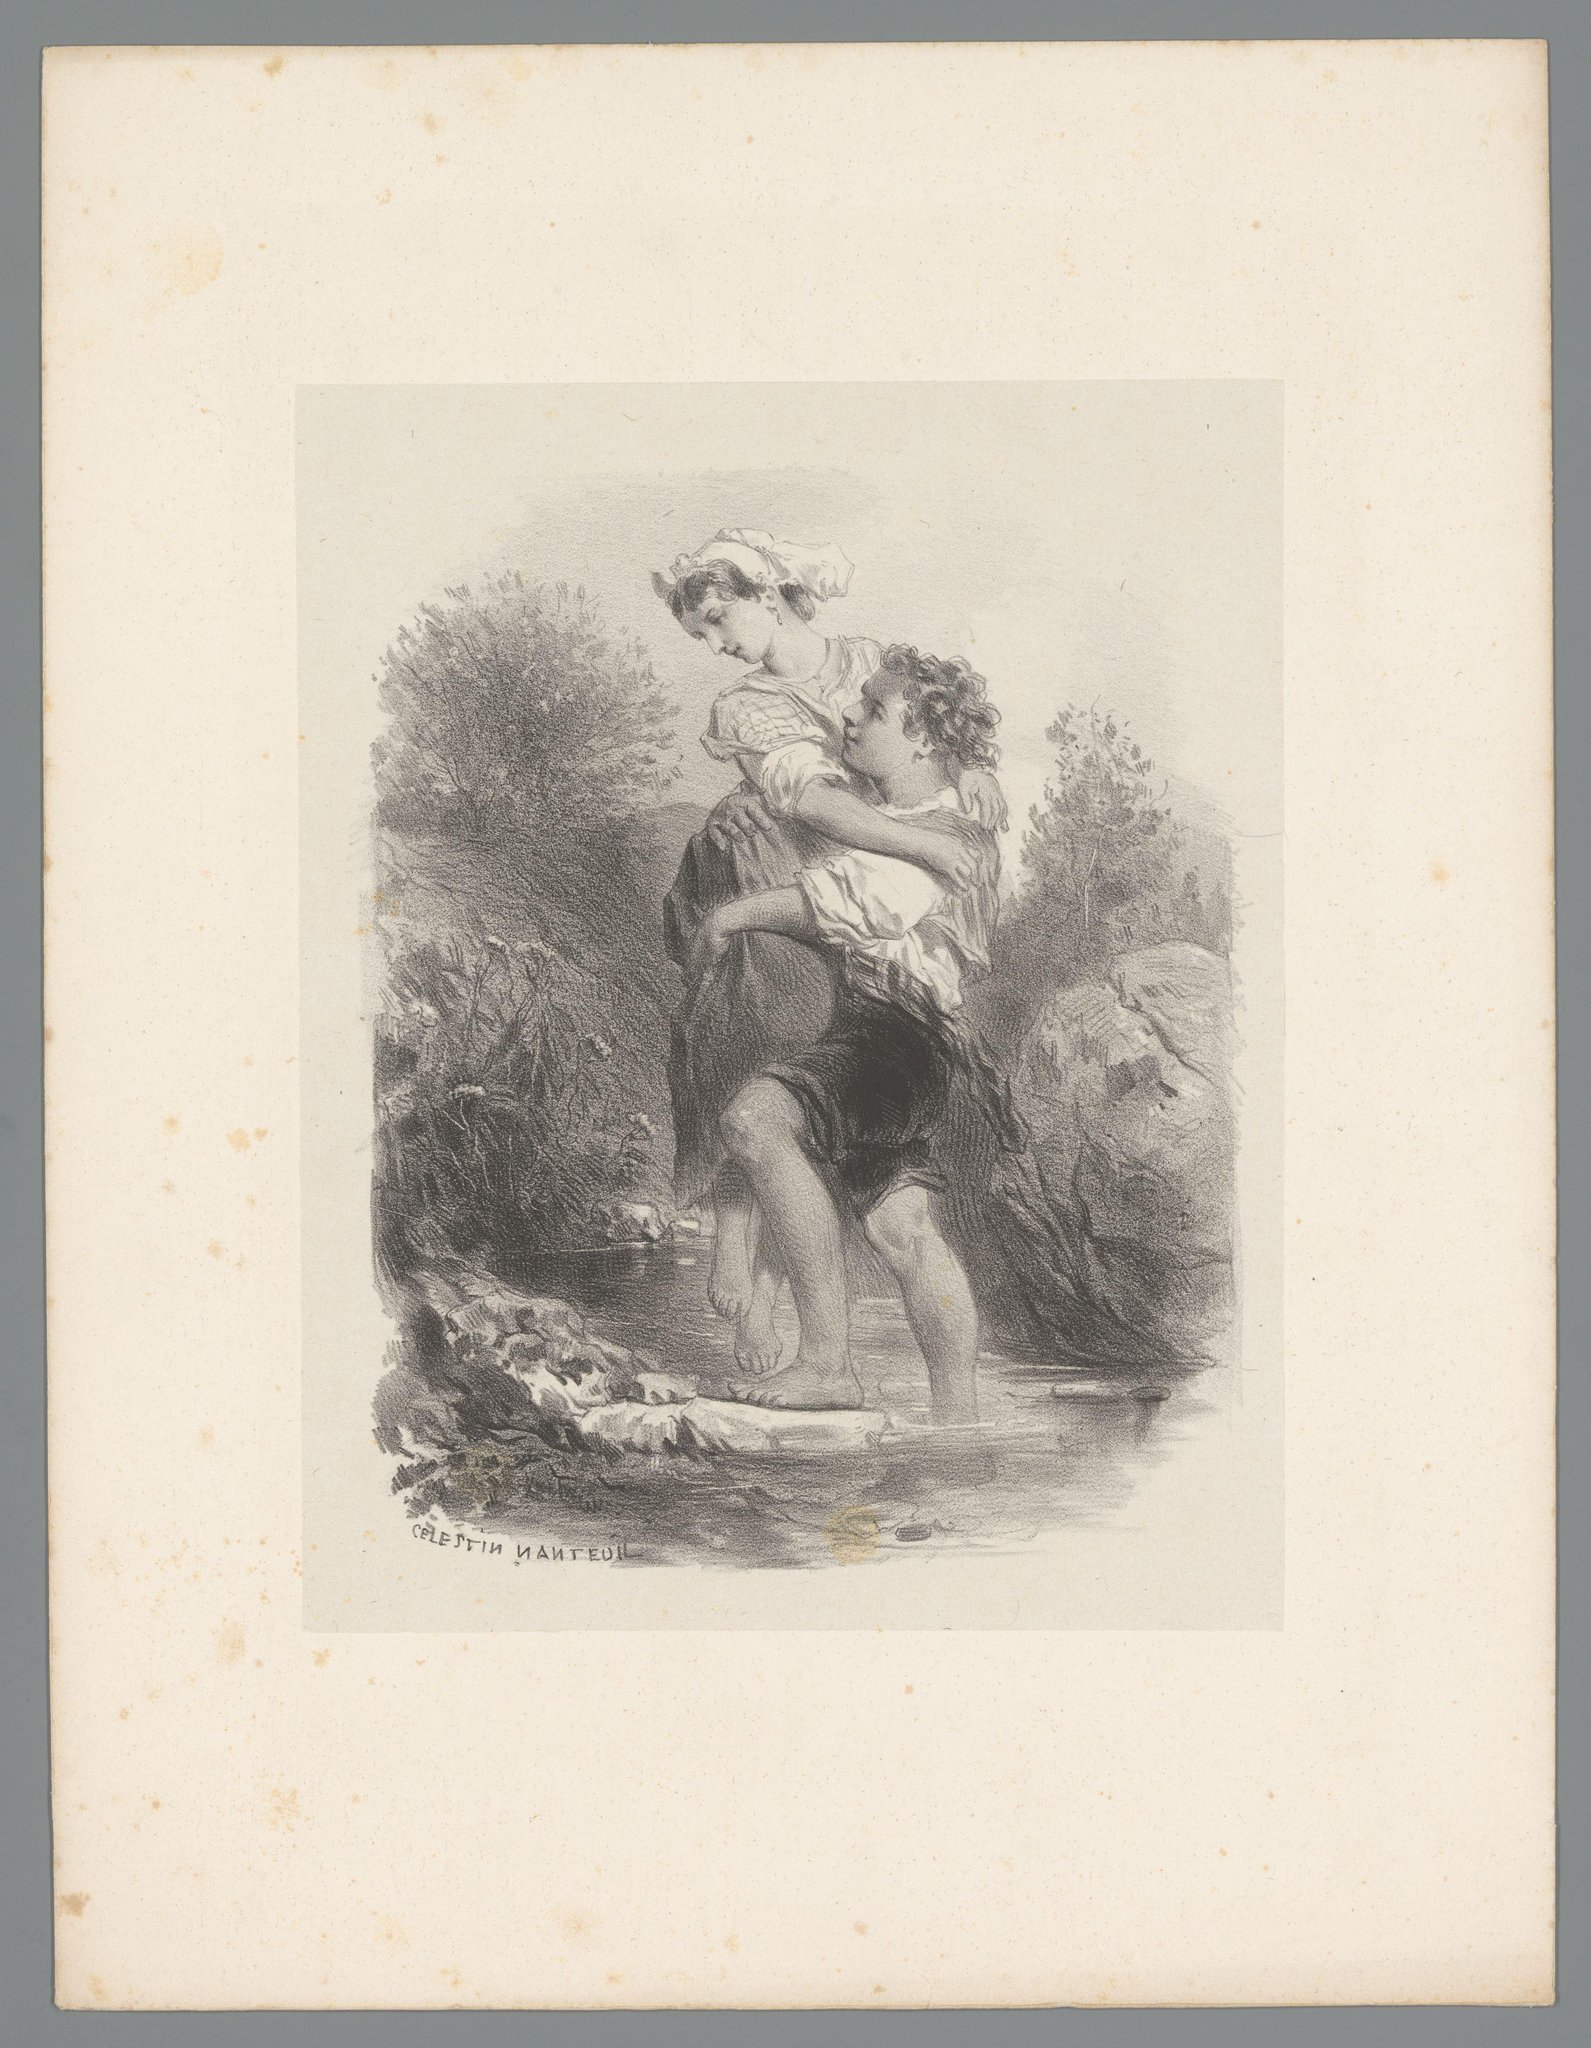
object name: print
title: Jonge man draagt een jonge vrouw over het water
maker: célestin françois nanteuil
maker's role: print maker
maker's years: 1813-1873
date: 1823-1873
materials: paper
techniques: lithograph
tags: carrying a person, river, lovers' meeting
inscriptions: collector's mark: Lugt 964